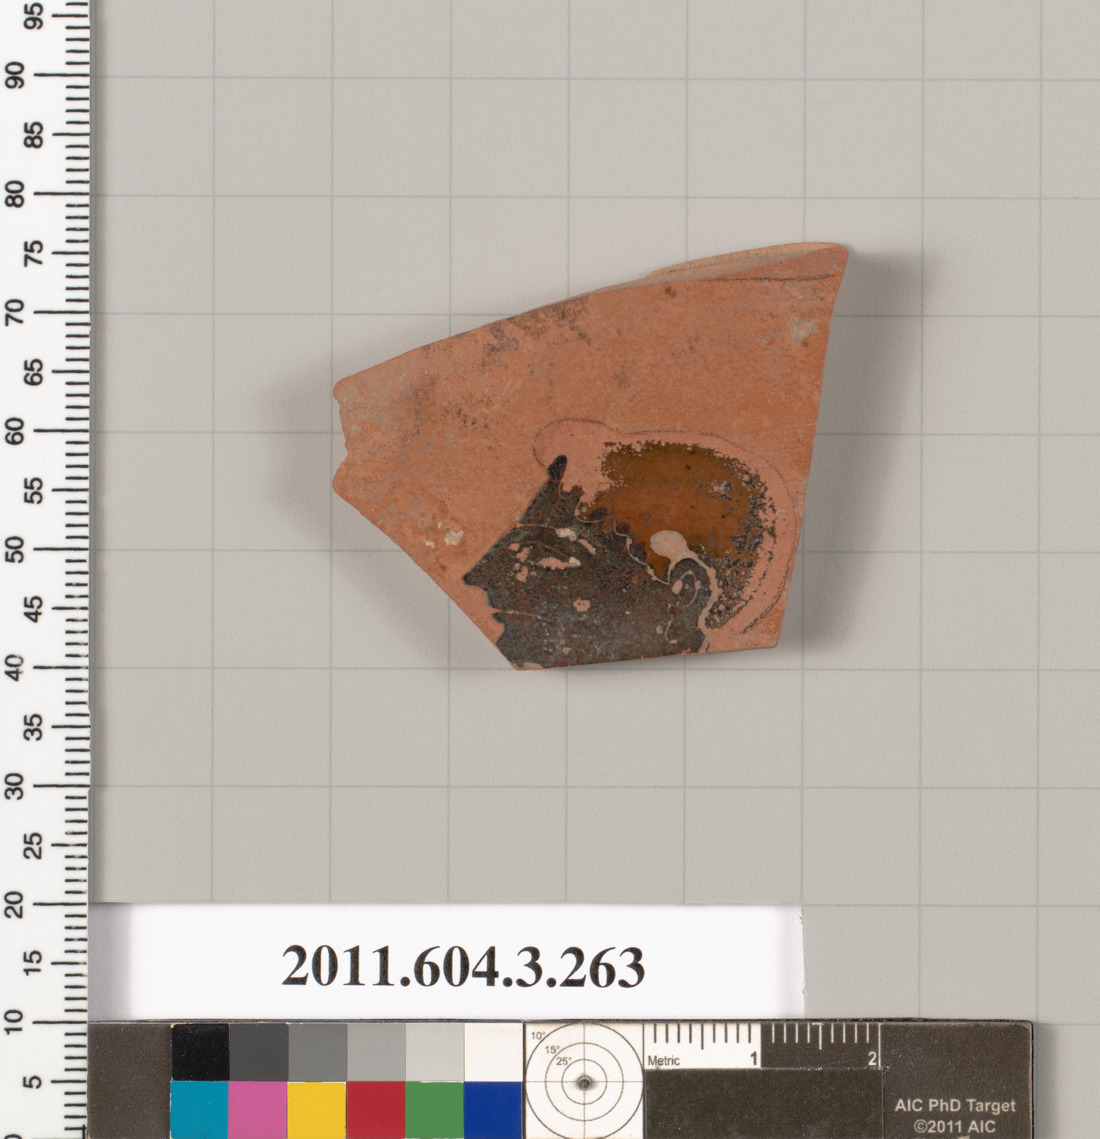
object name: neck amphora fragment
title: Terracotta fragment of a neck-amphora (jar)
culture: greek, attic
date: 534-468 BCE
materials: terracotta